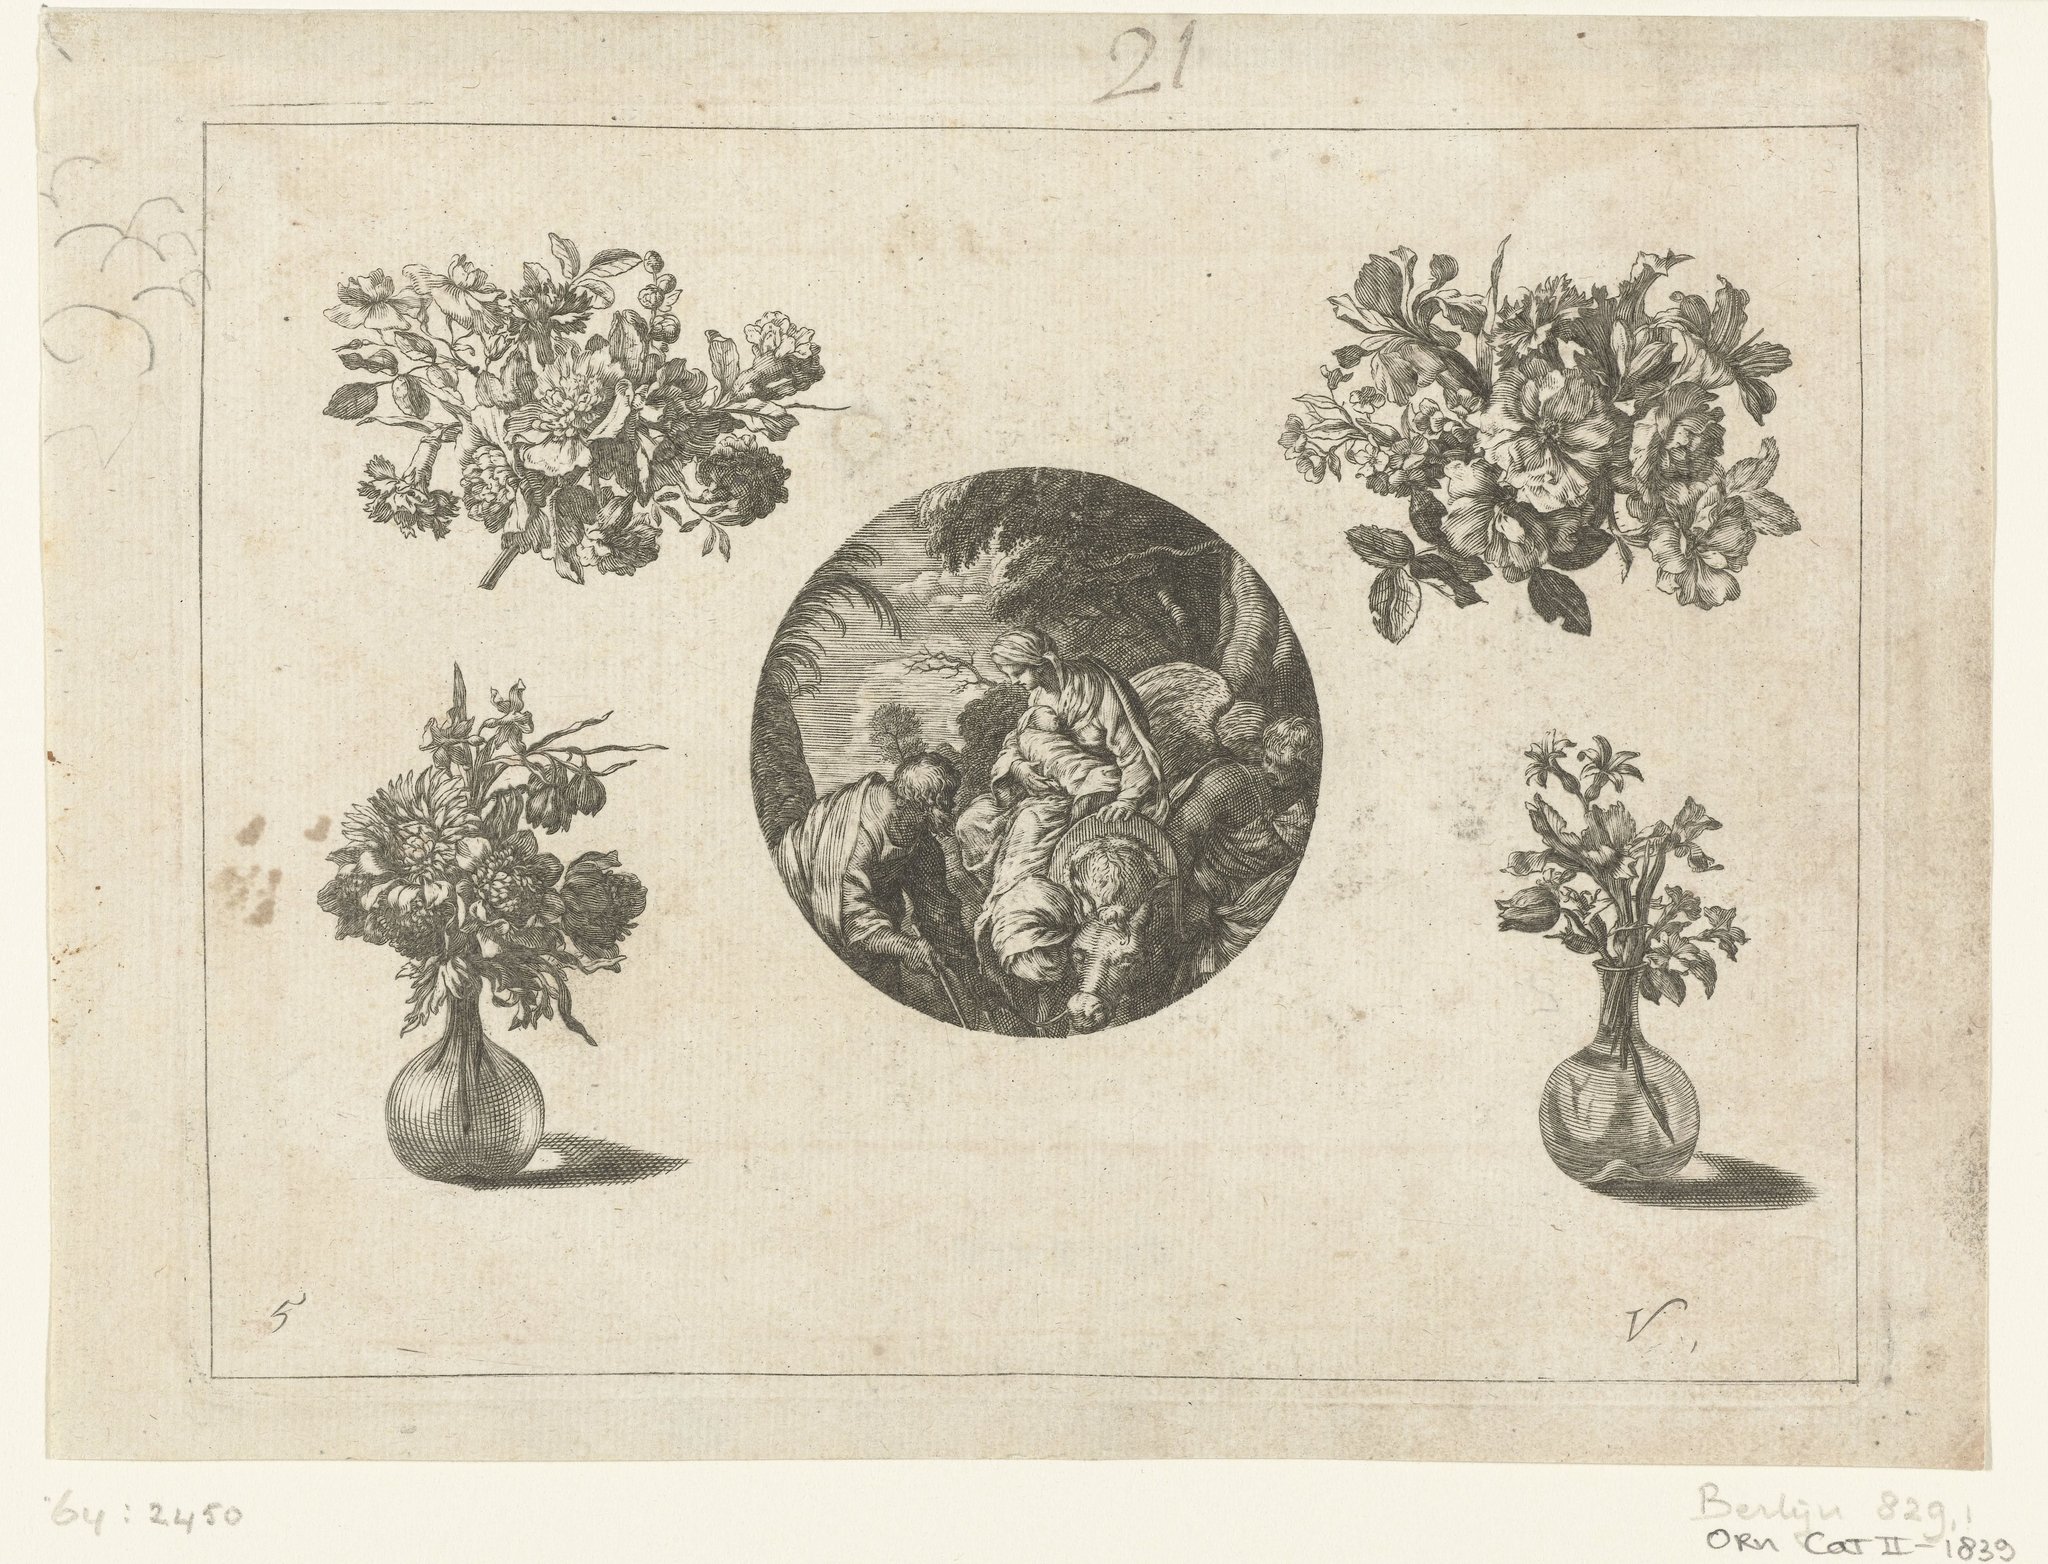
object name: print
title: Edelsmidsontwerpen voor horlogekasten: deksels en zijkanten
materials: paper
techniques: engraving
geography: france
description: Horlogekast met de Vlucht naar Egypte. Eerste editie, tweede druk.